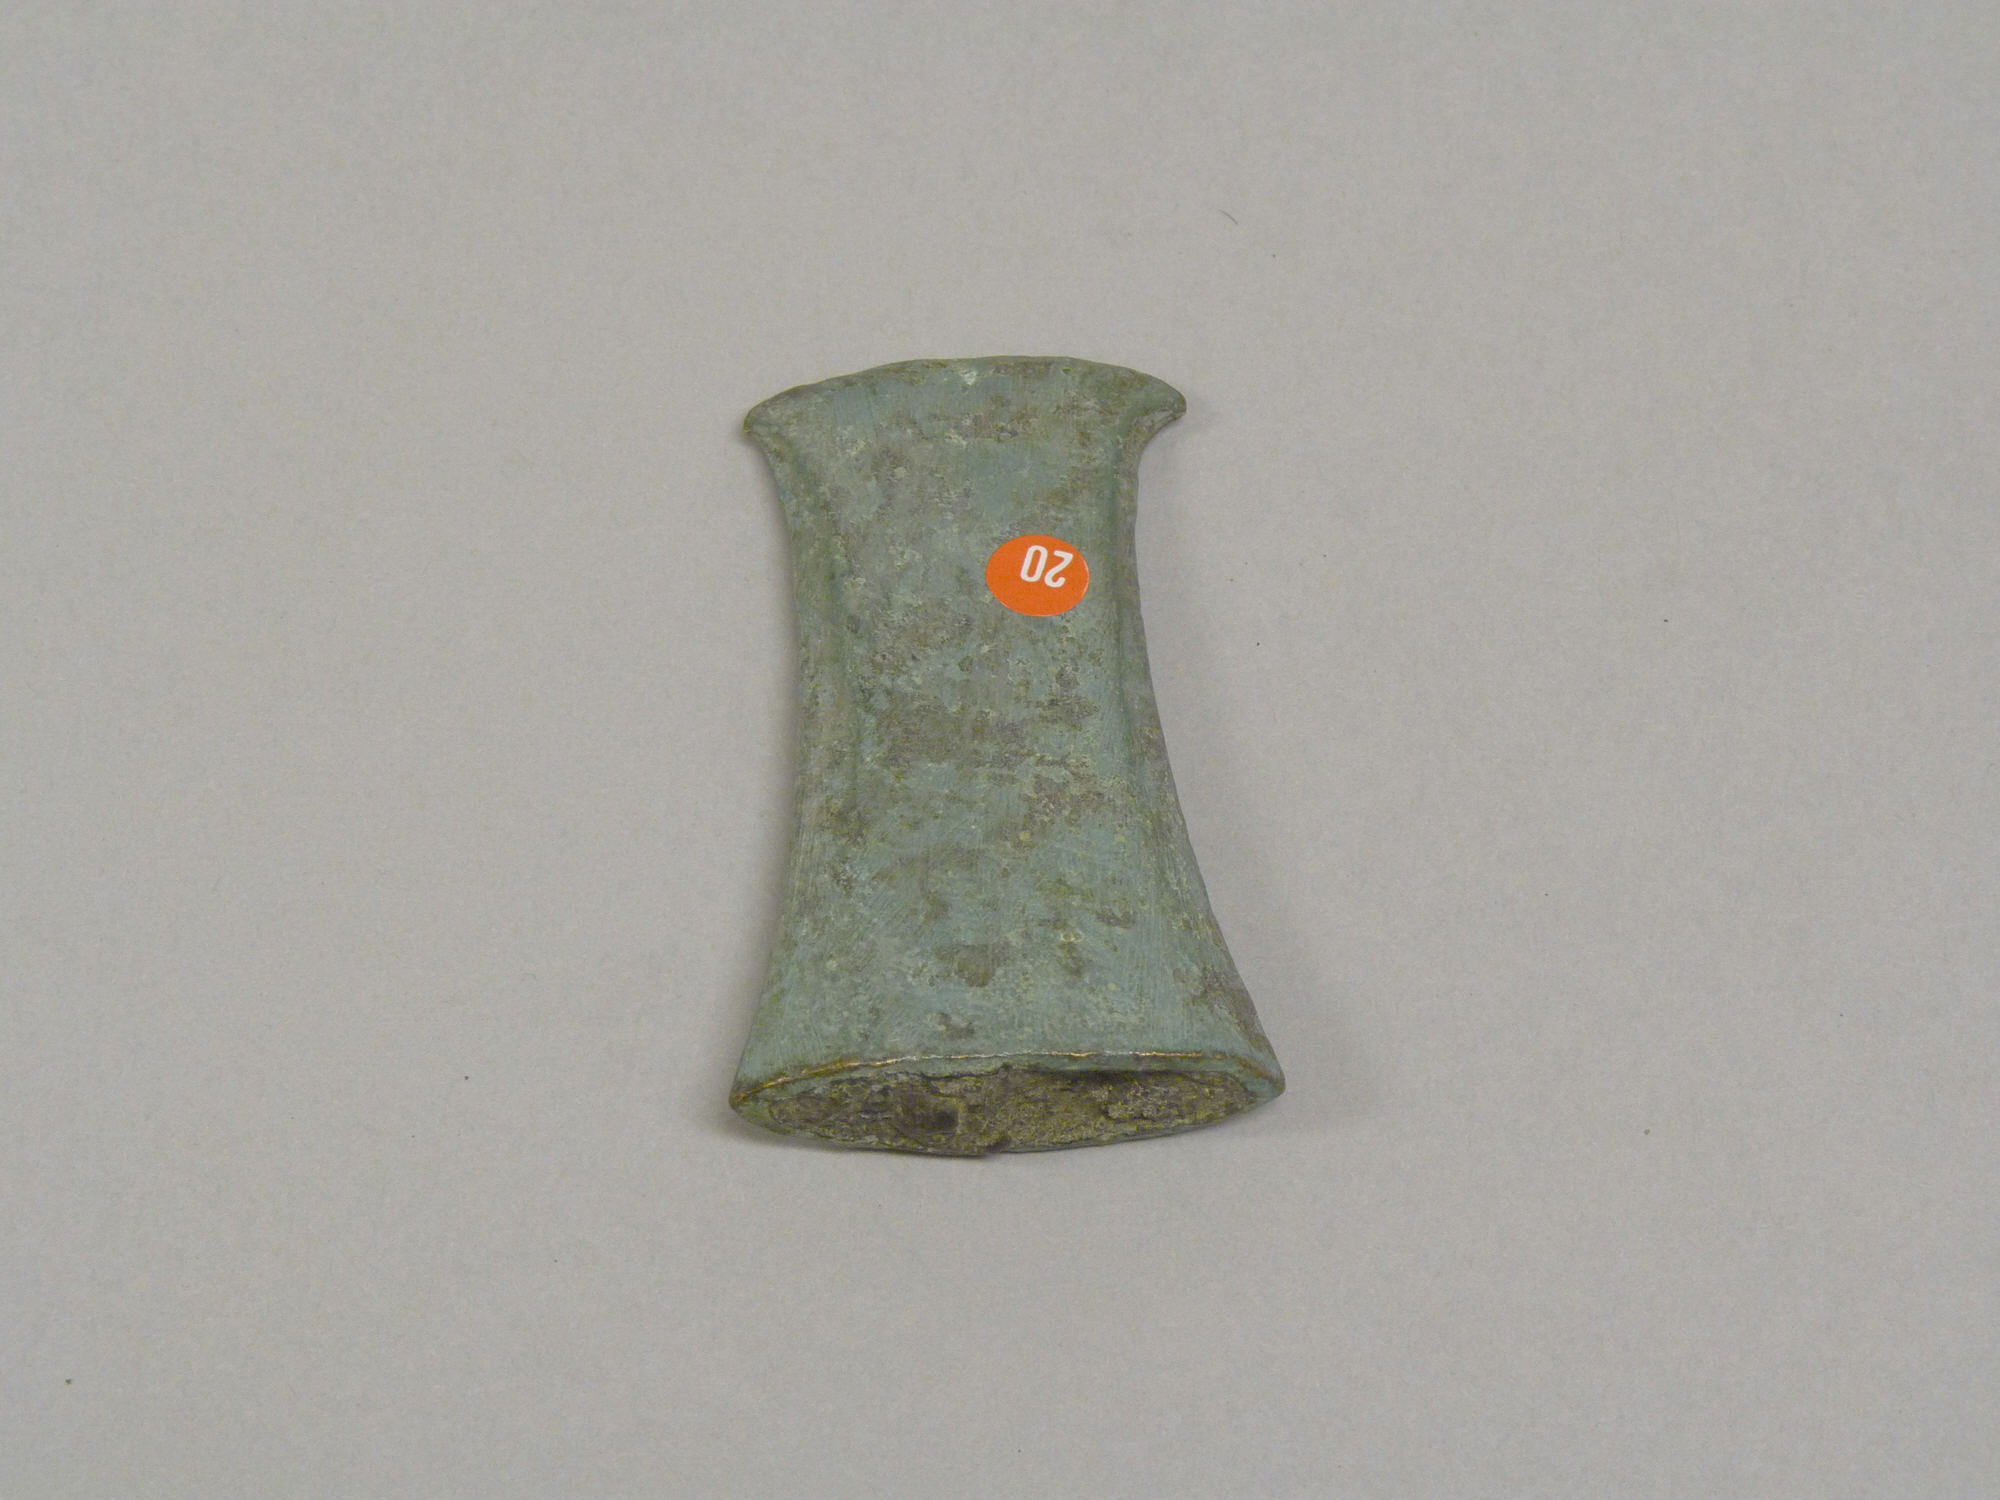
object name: drum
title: Socketed Drum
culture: thai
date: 500 BCE-300 CE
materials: bronze